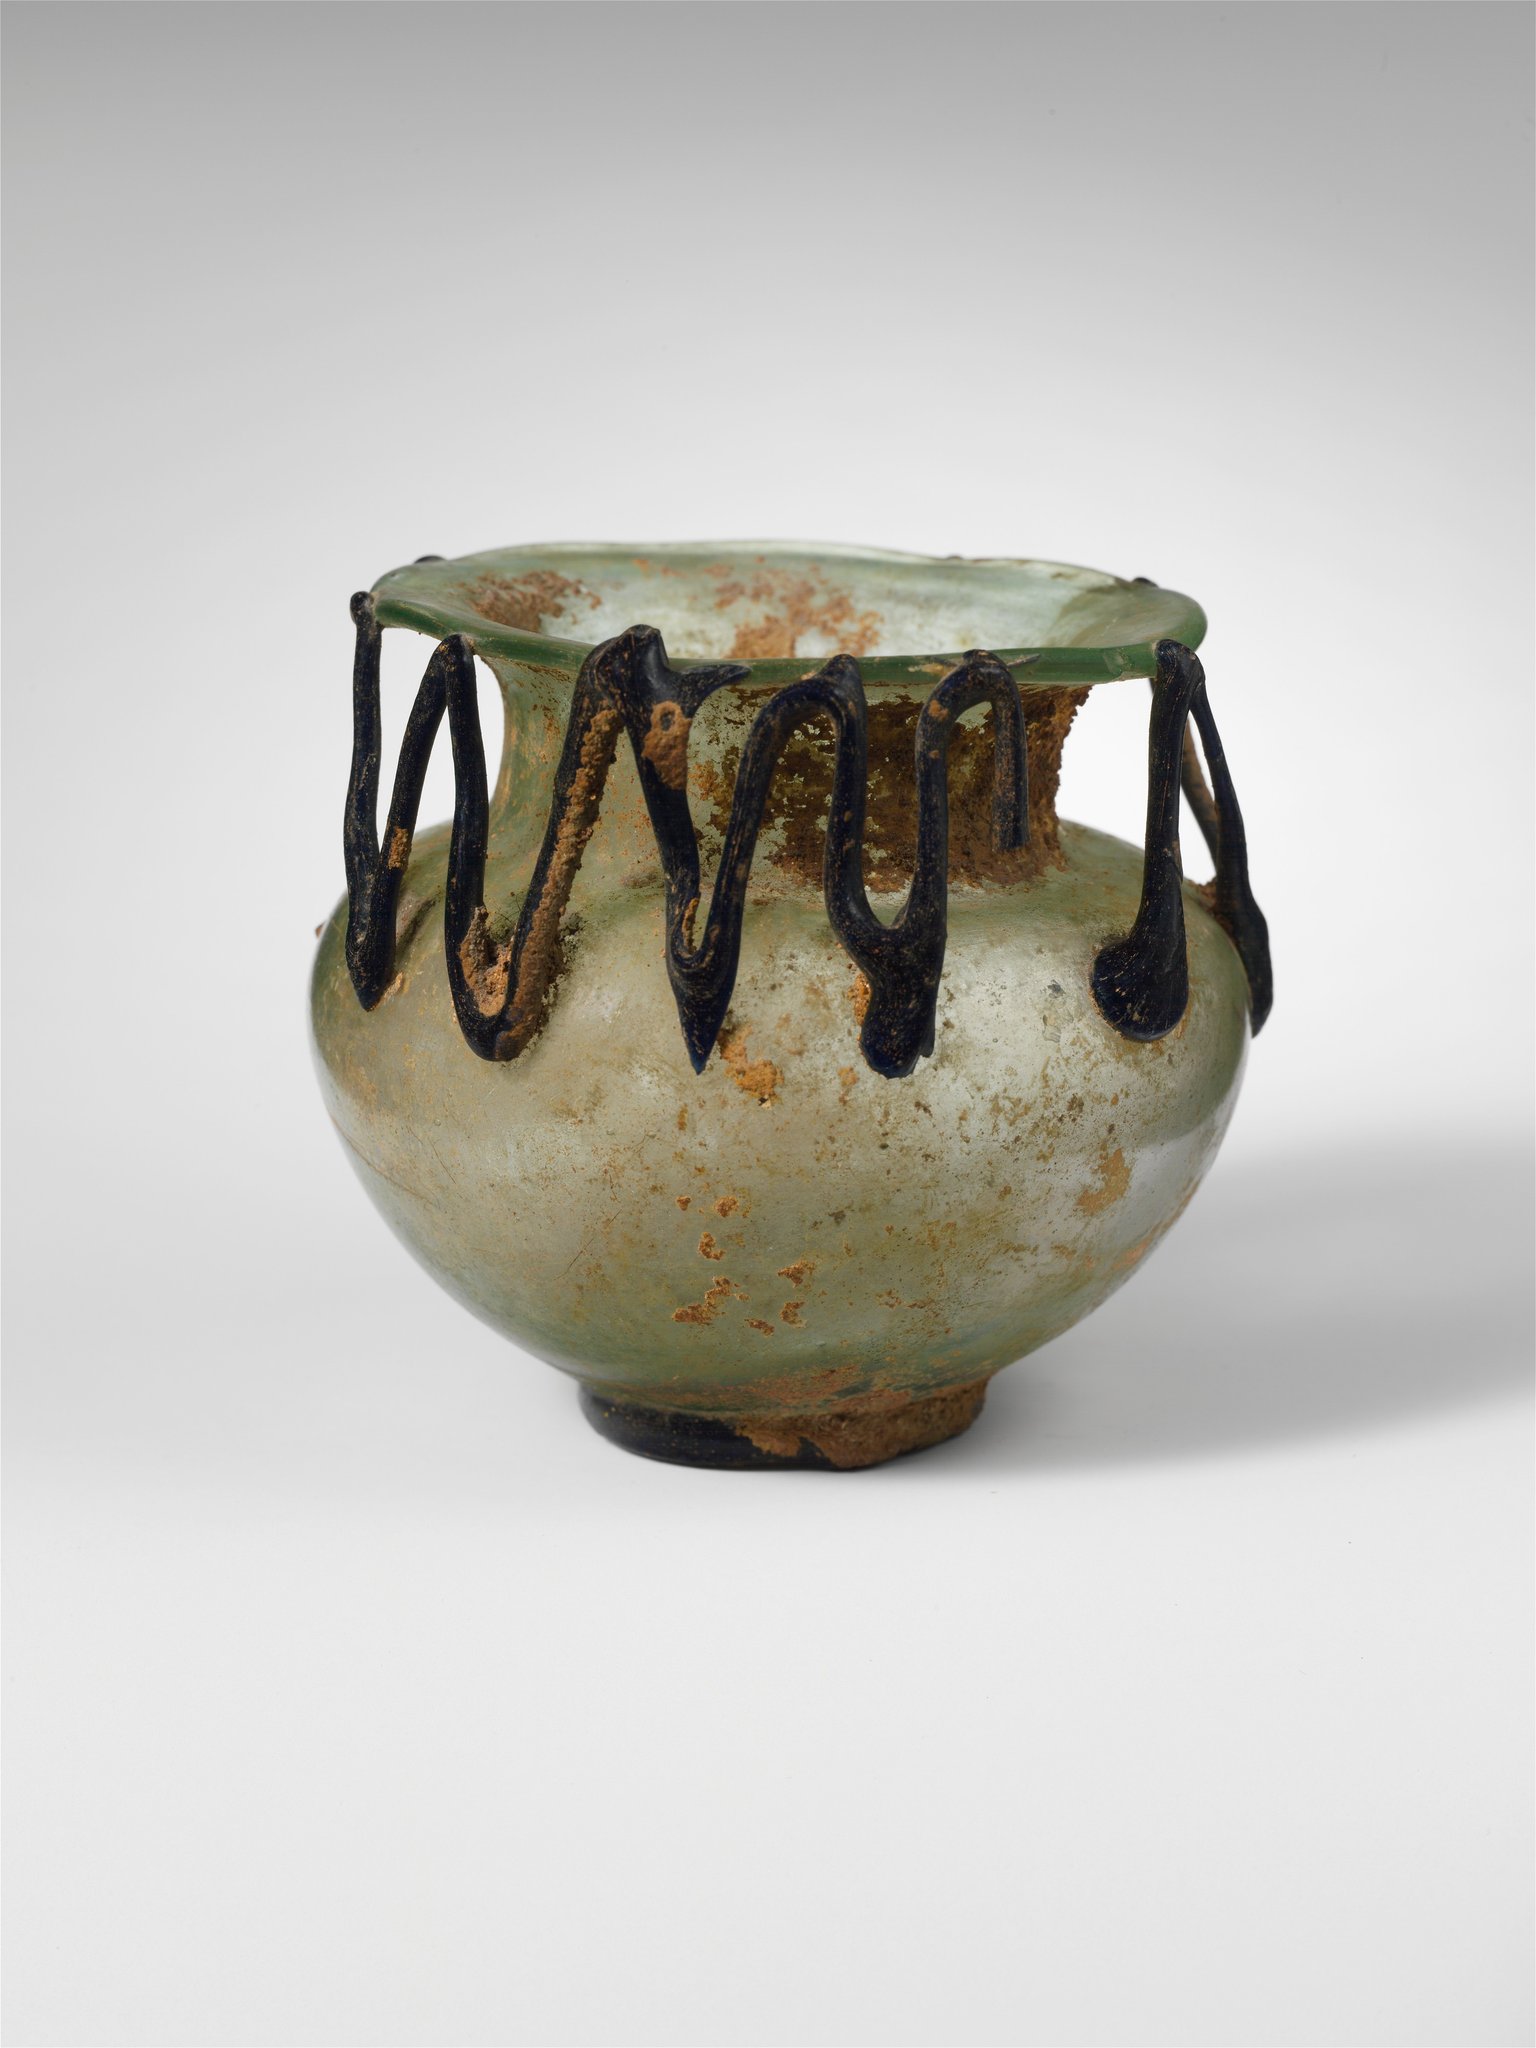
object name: jar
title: Glass jar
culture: roman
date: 301-400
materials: glass